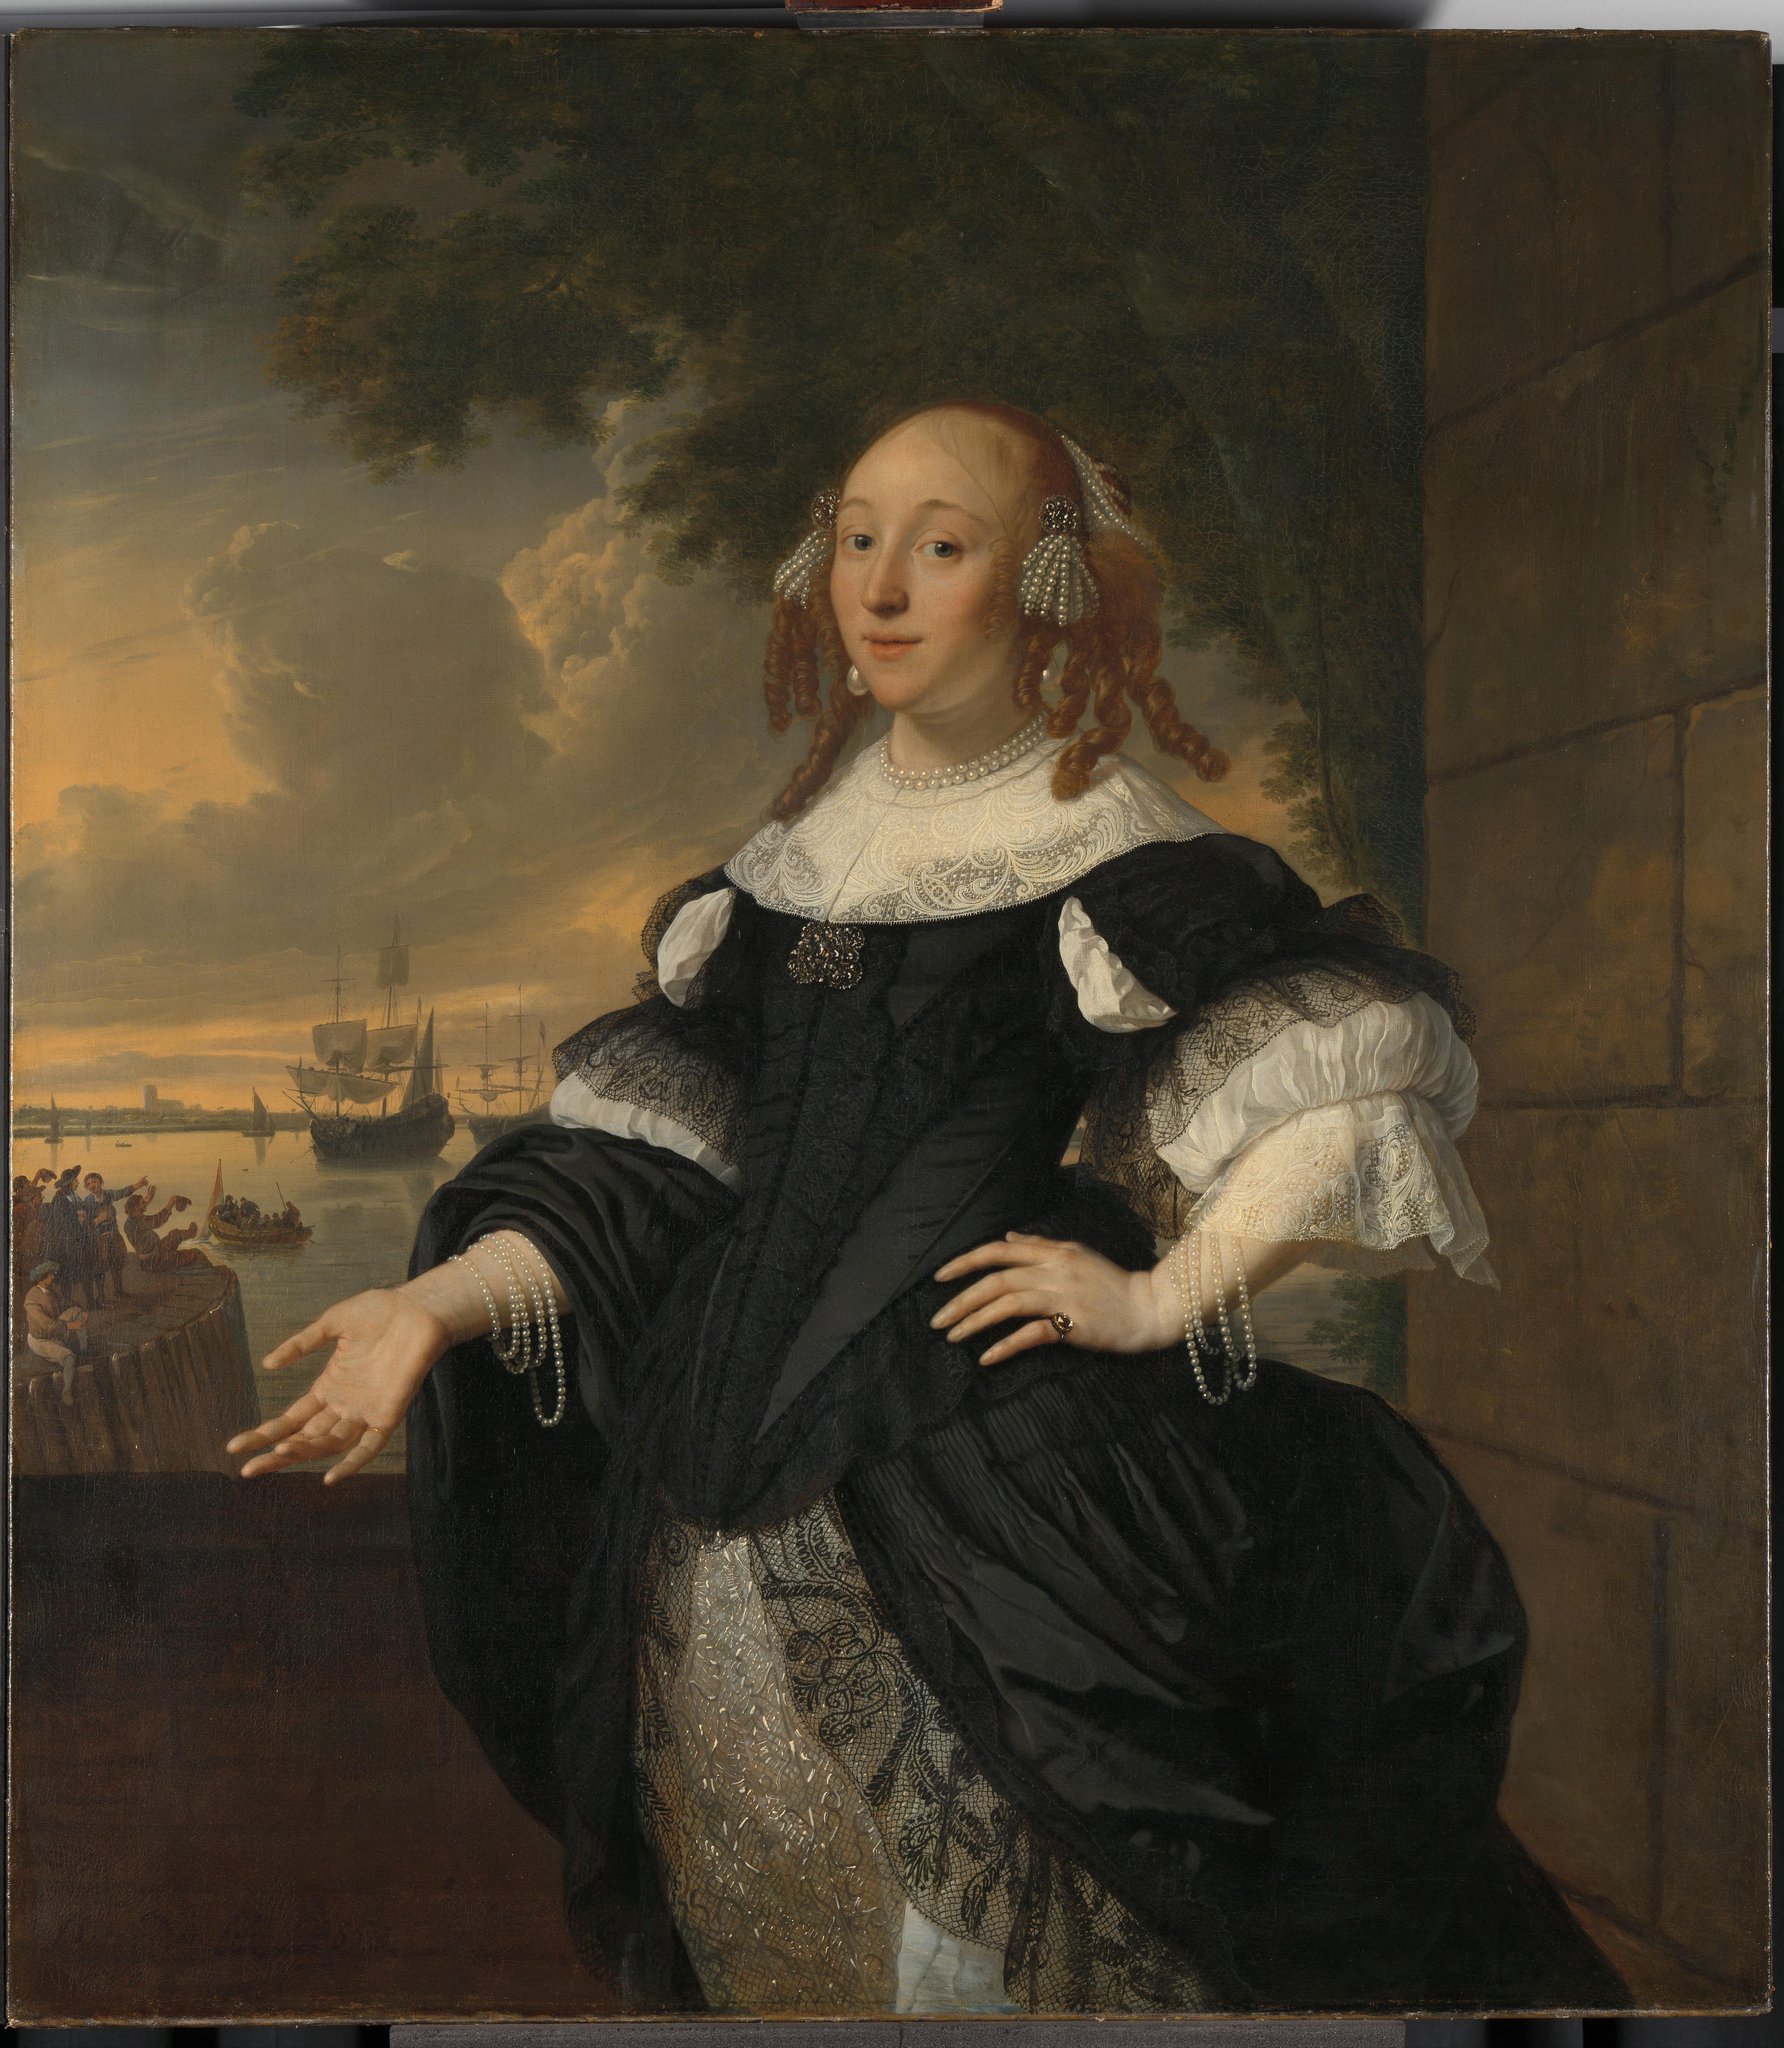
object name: painting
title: Geertruida den Dubbelde (1647-84), Wife of Aert van Nes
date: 1668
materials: canvas, oil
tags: harbour, historical persons - bb - woman, bracelet, wristlet, pearl; pearl necklace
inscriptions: signature and date: ‘B. van der Helst f. 1668’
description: Portret van Geertruida den Dubbelde, de echtgenote van luitenant-admiraal Aert van Nes. Kniestuk, staand voor een balustrade met uitzicht op een haven met oorlogsschepen en mensen op de kade. Sieraden met parels in het haar en om de polsen. De rechterhand uitgestoken, de linker in de zij. Pendant van SK-A-140.